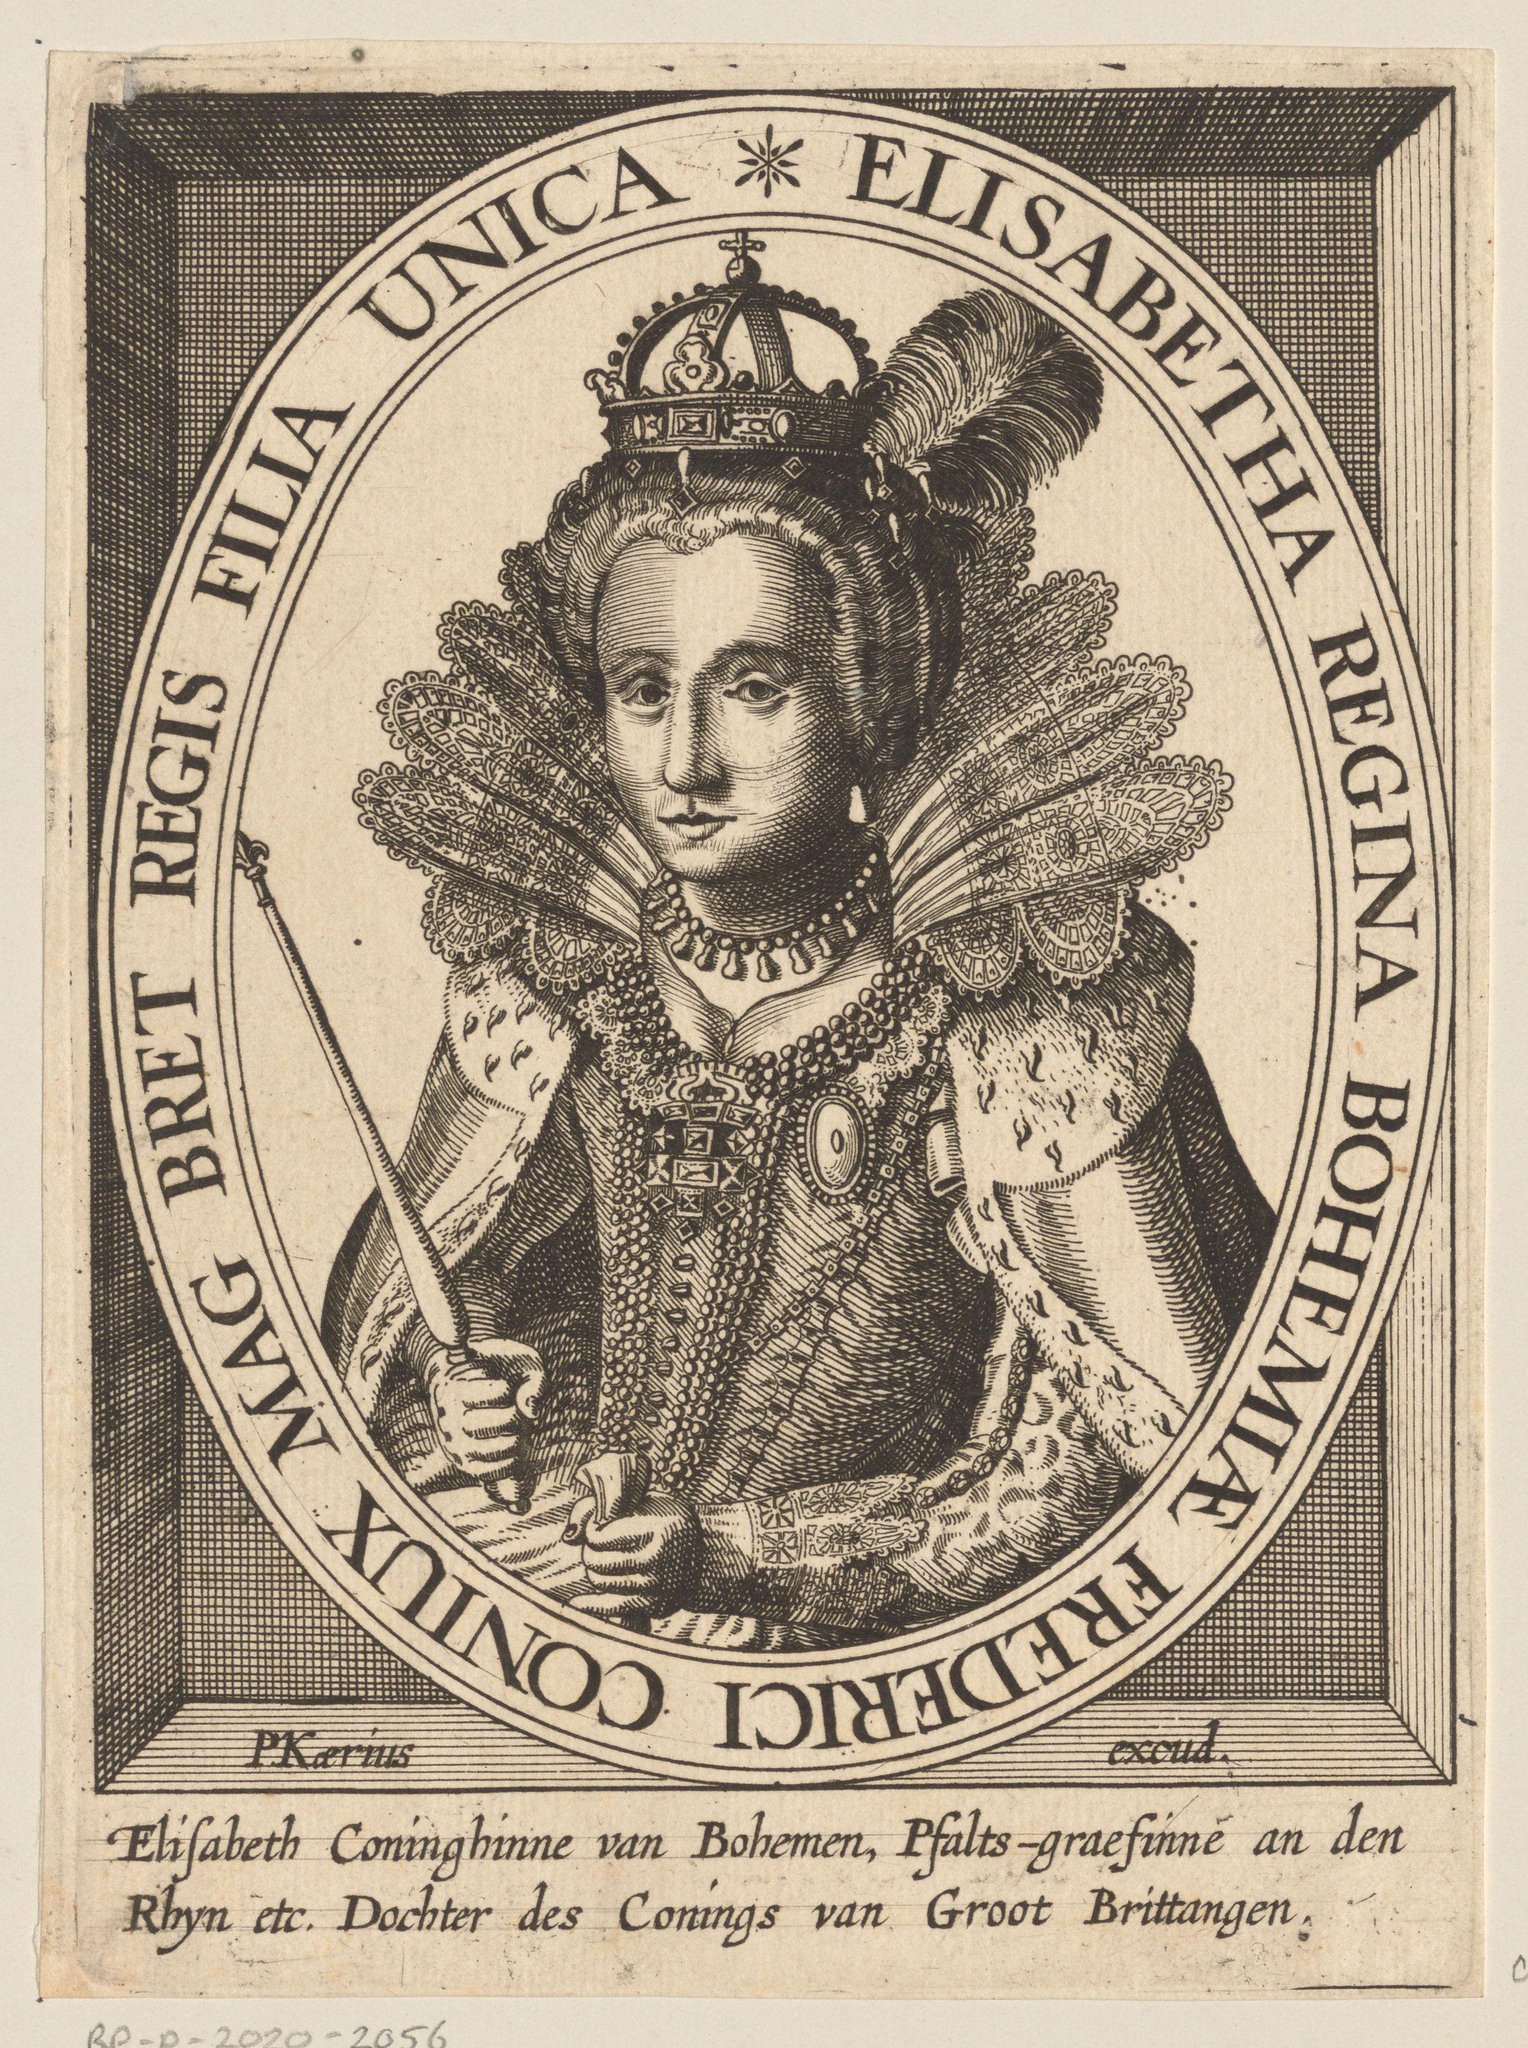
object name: print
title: Portret van Elisabeth Stuart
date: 1619-1646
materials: paper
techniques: engraving, etching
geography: northern netherlands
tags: crown (symbol of sovereignty), historical persons - bb - woman, queen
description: Portret van Elisabeth Stuart als koningin van Bohemen.